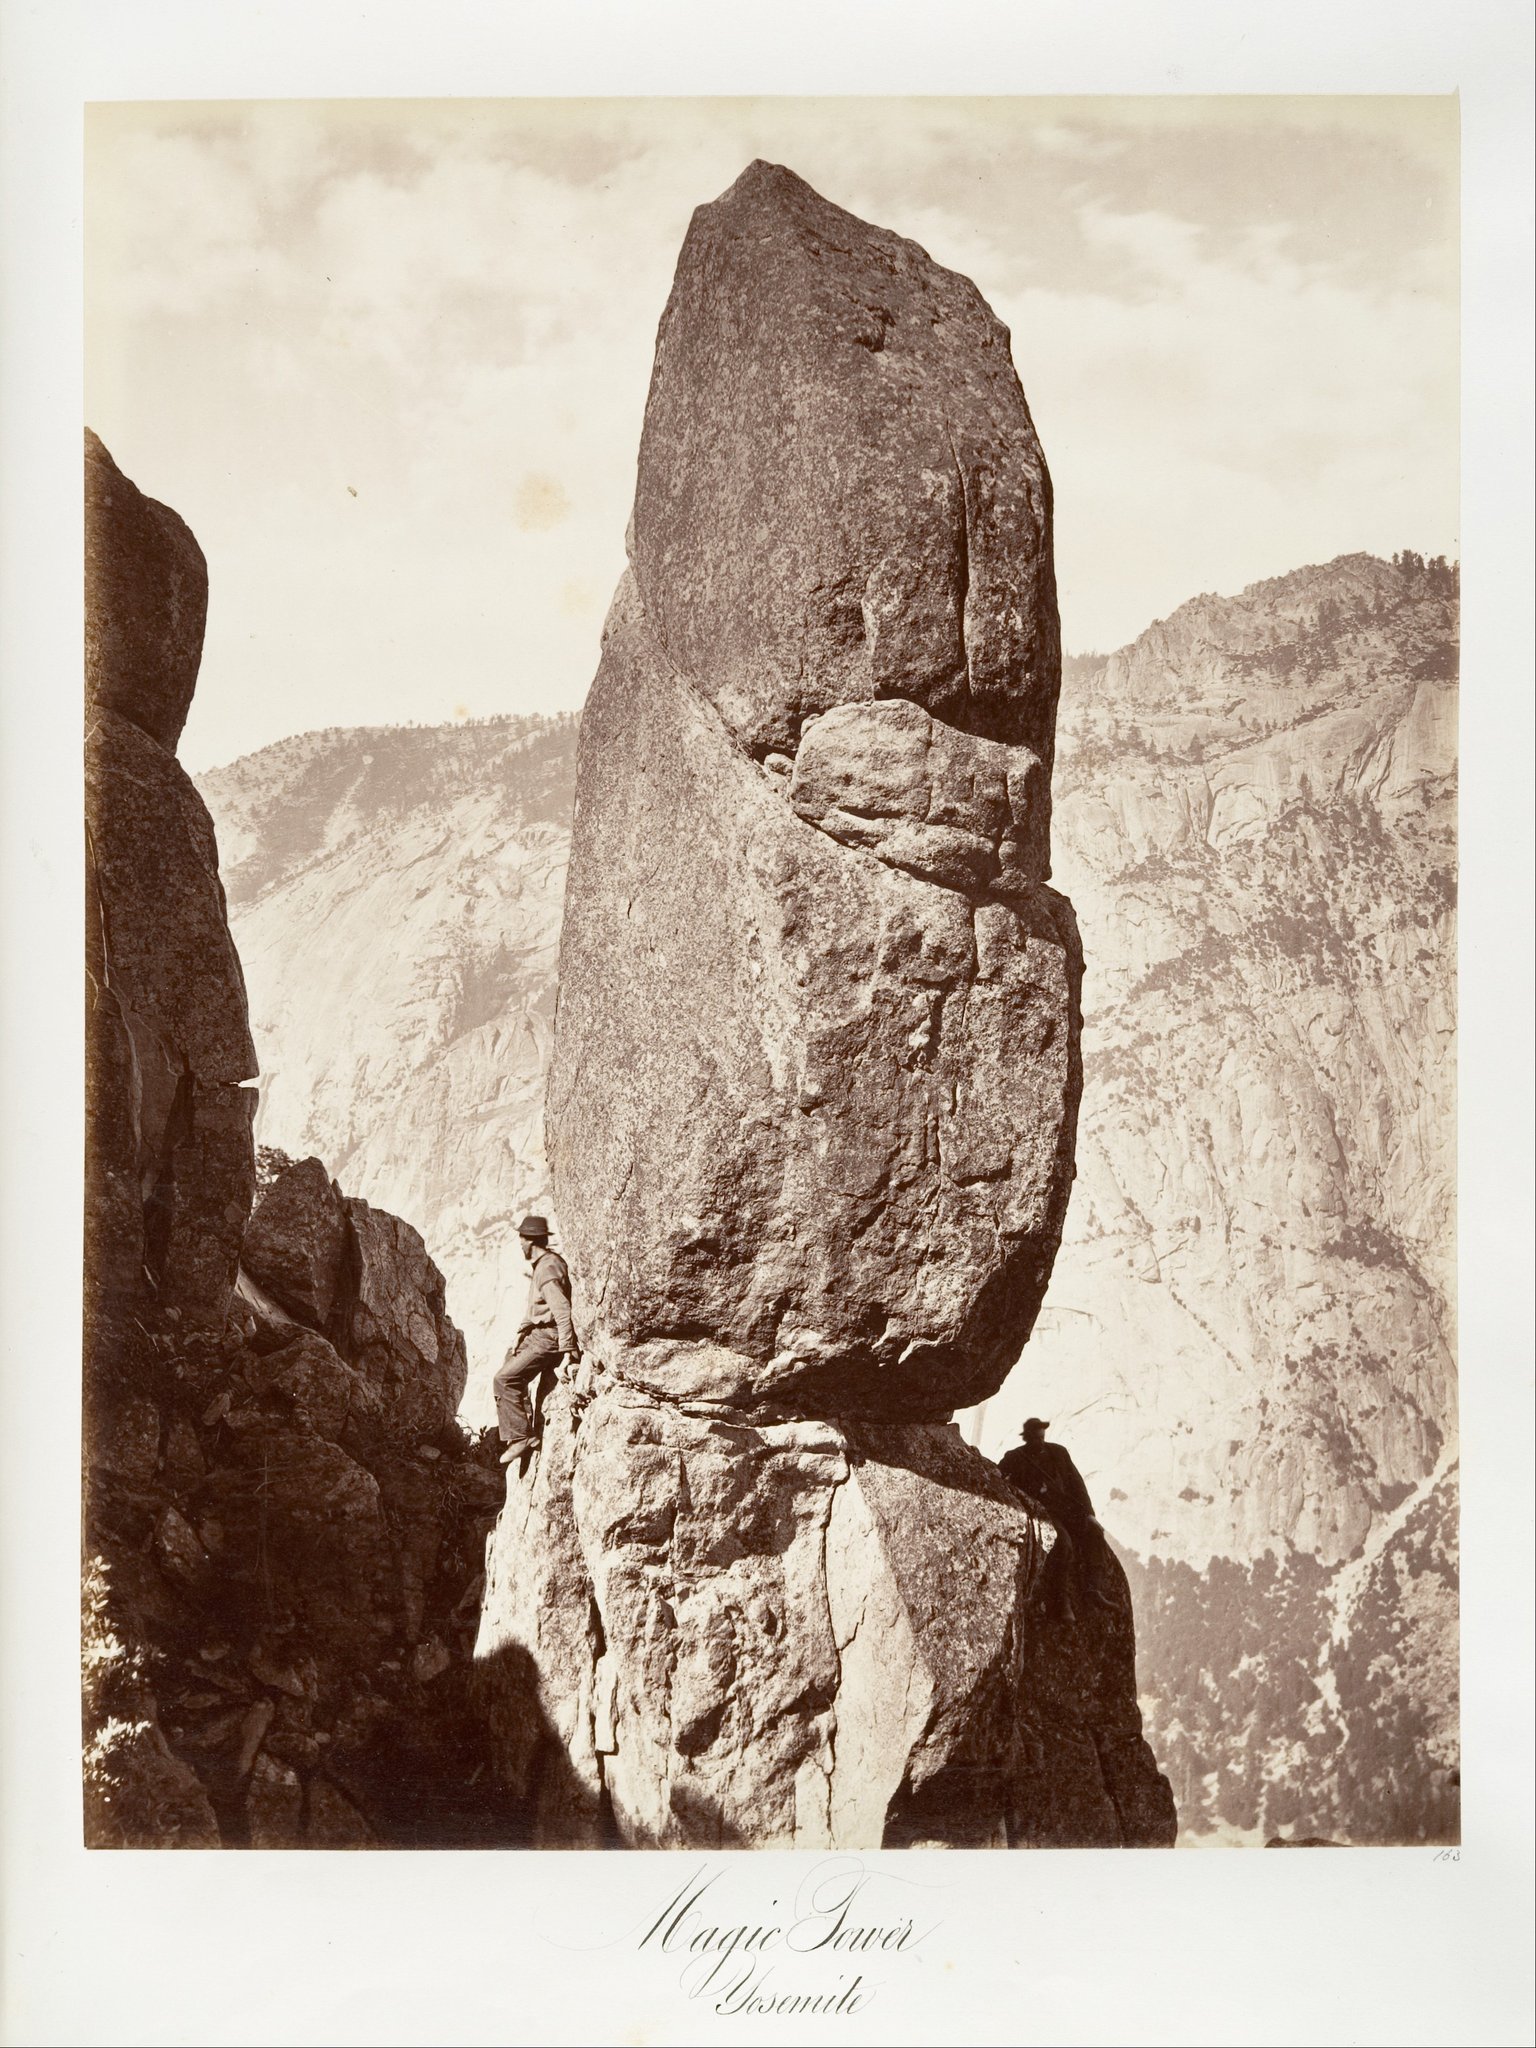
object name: photograph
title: Magic Tower, Yosemite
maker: carleton e. watkins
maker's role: artist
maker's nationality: american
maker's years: 1829-1916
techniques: albumen silver print, glass negative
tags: men,mountains,landscapes